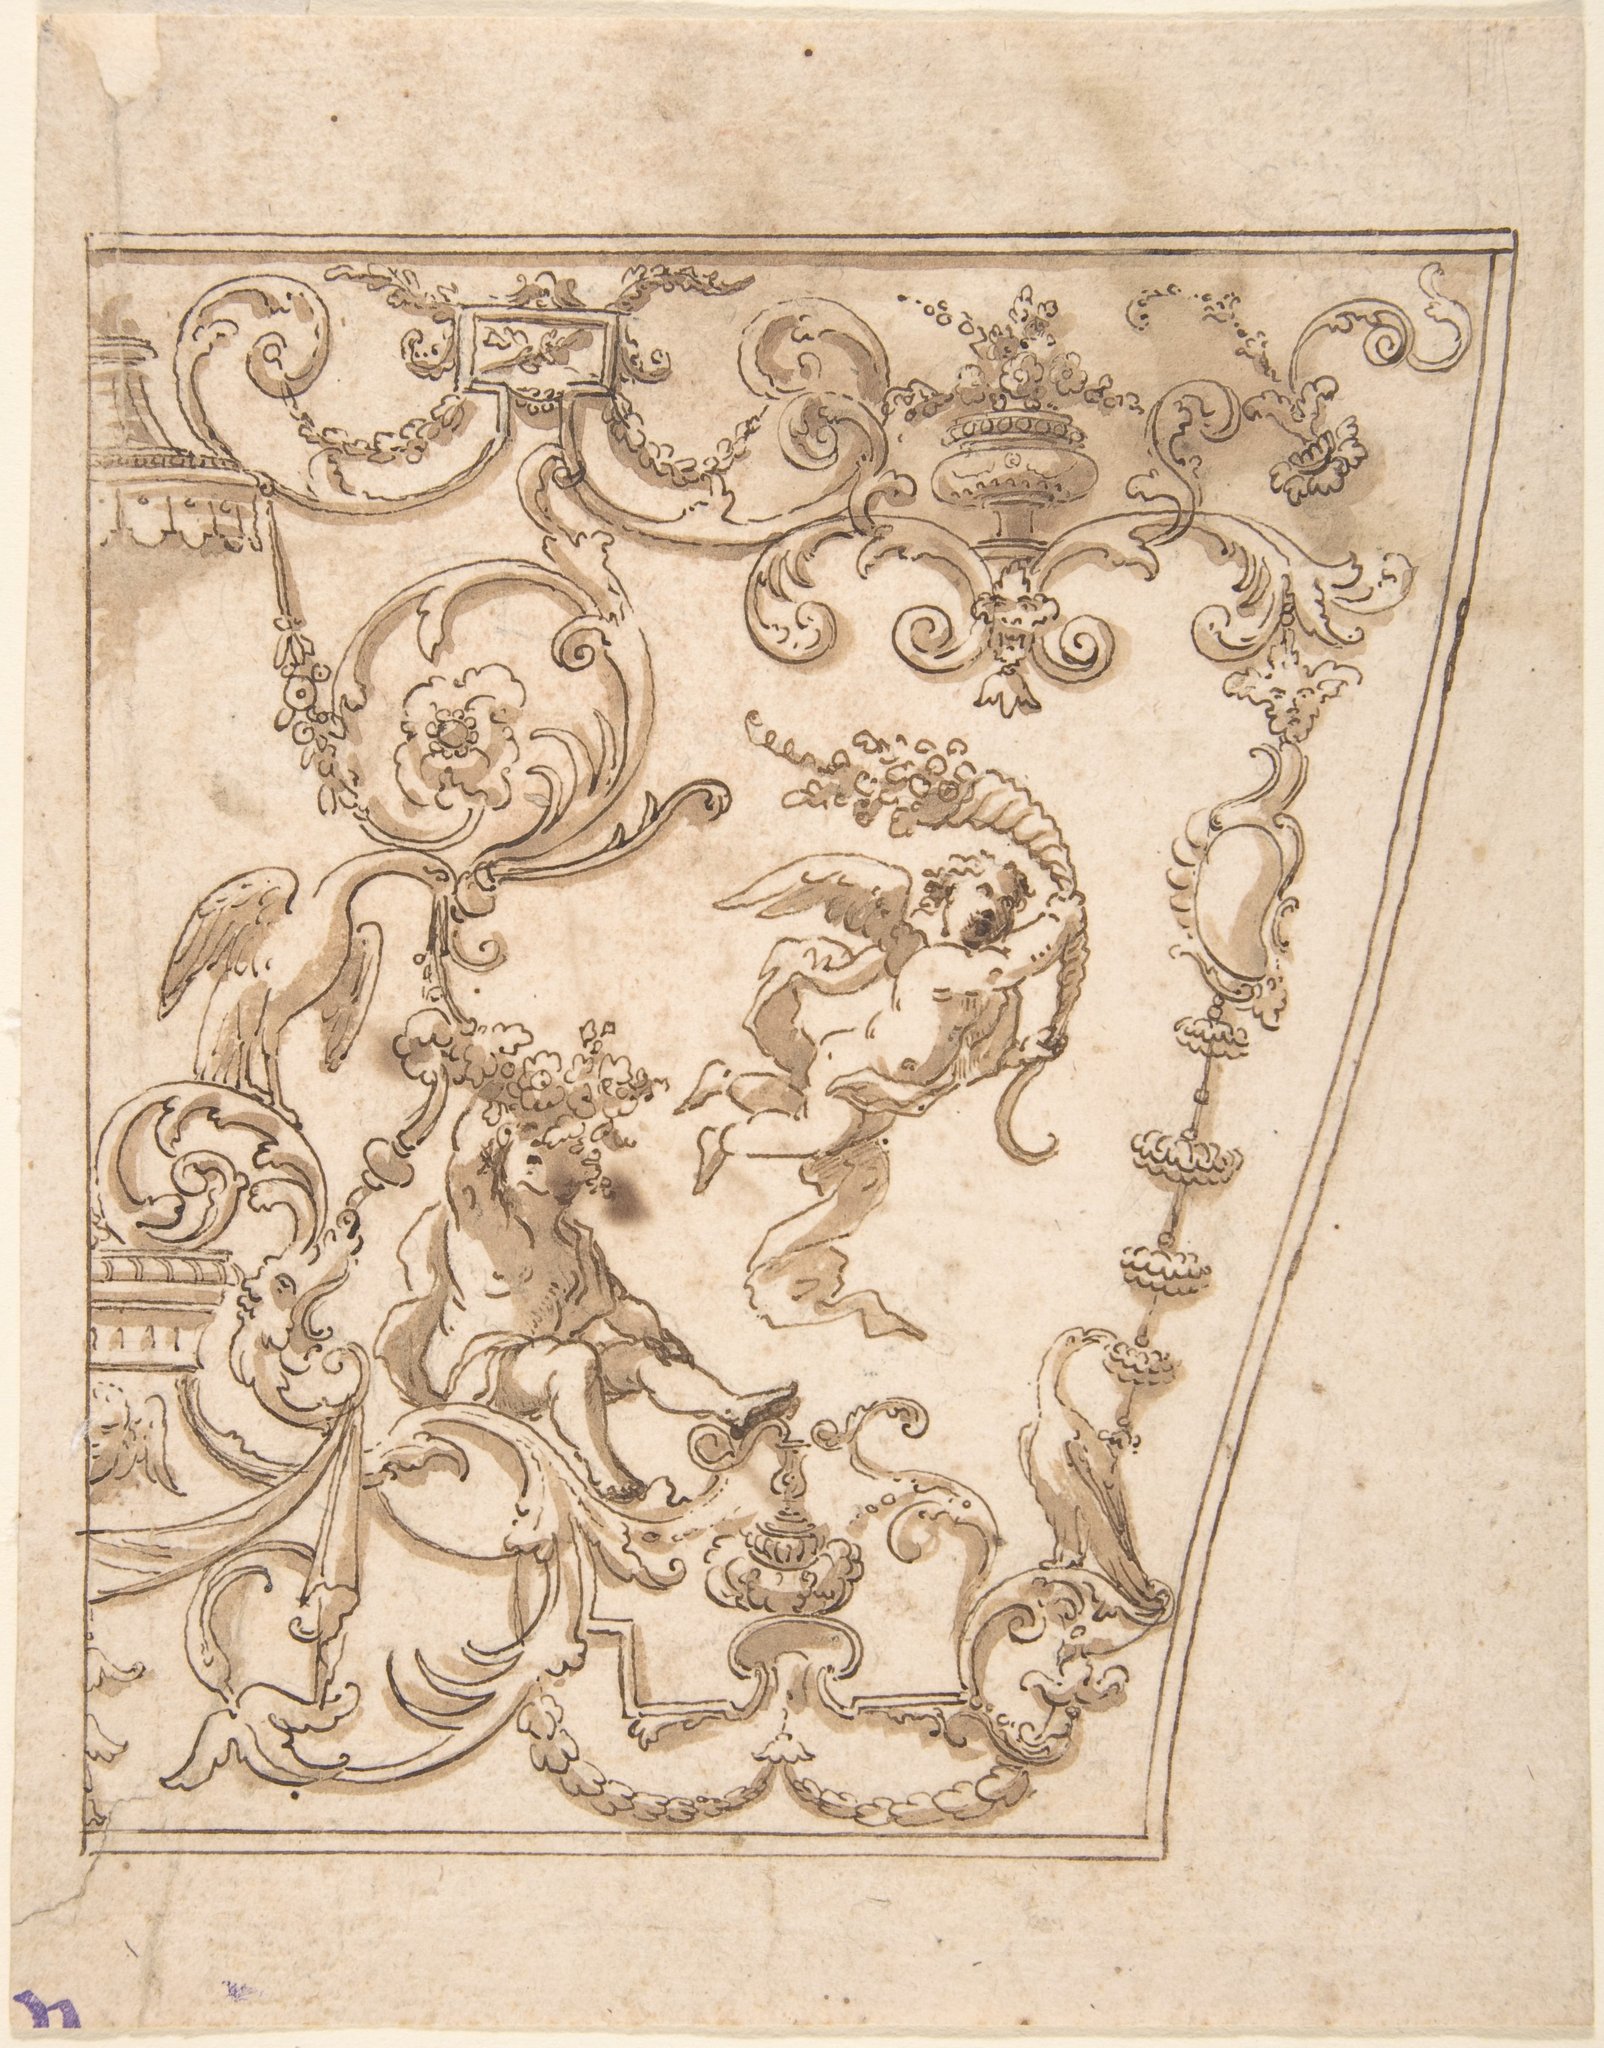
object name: drawing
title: Design for the Decorated Panel of a Carriage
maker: anonymous, italian, 18th century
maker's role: artist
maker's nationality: italian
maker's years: 1700-1800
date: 1701-1800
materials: chalk, ink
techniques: brush, pen, wash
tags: birds,ornament